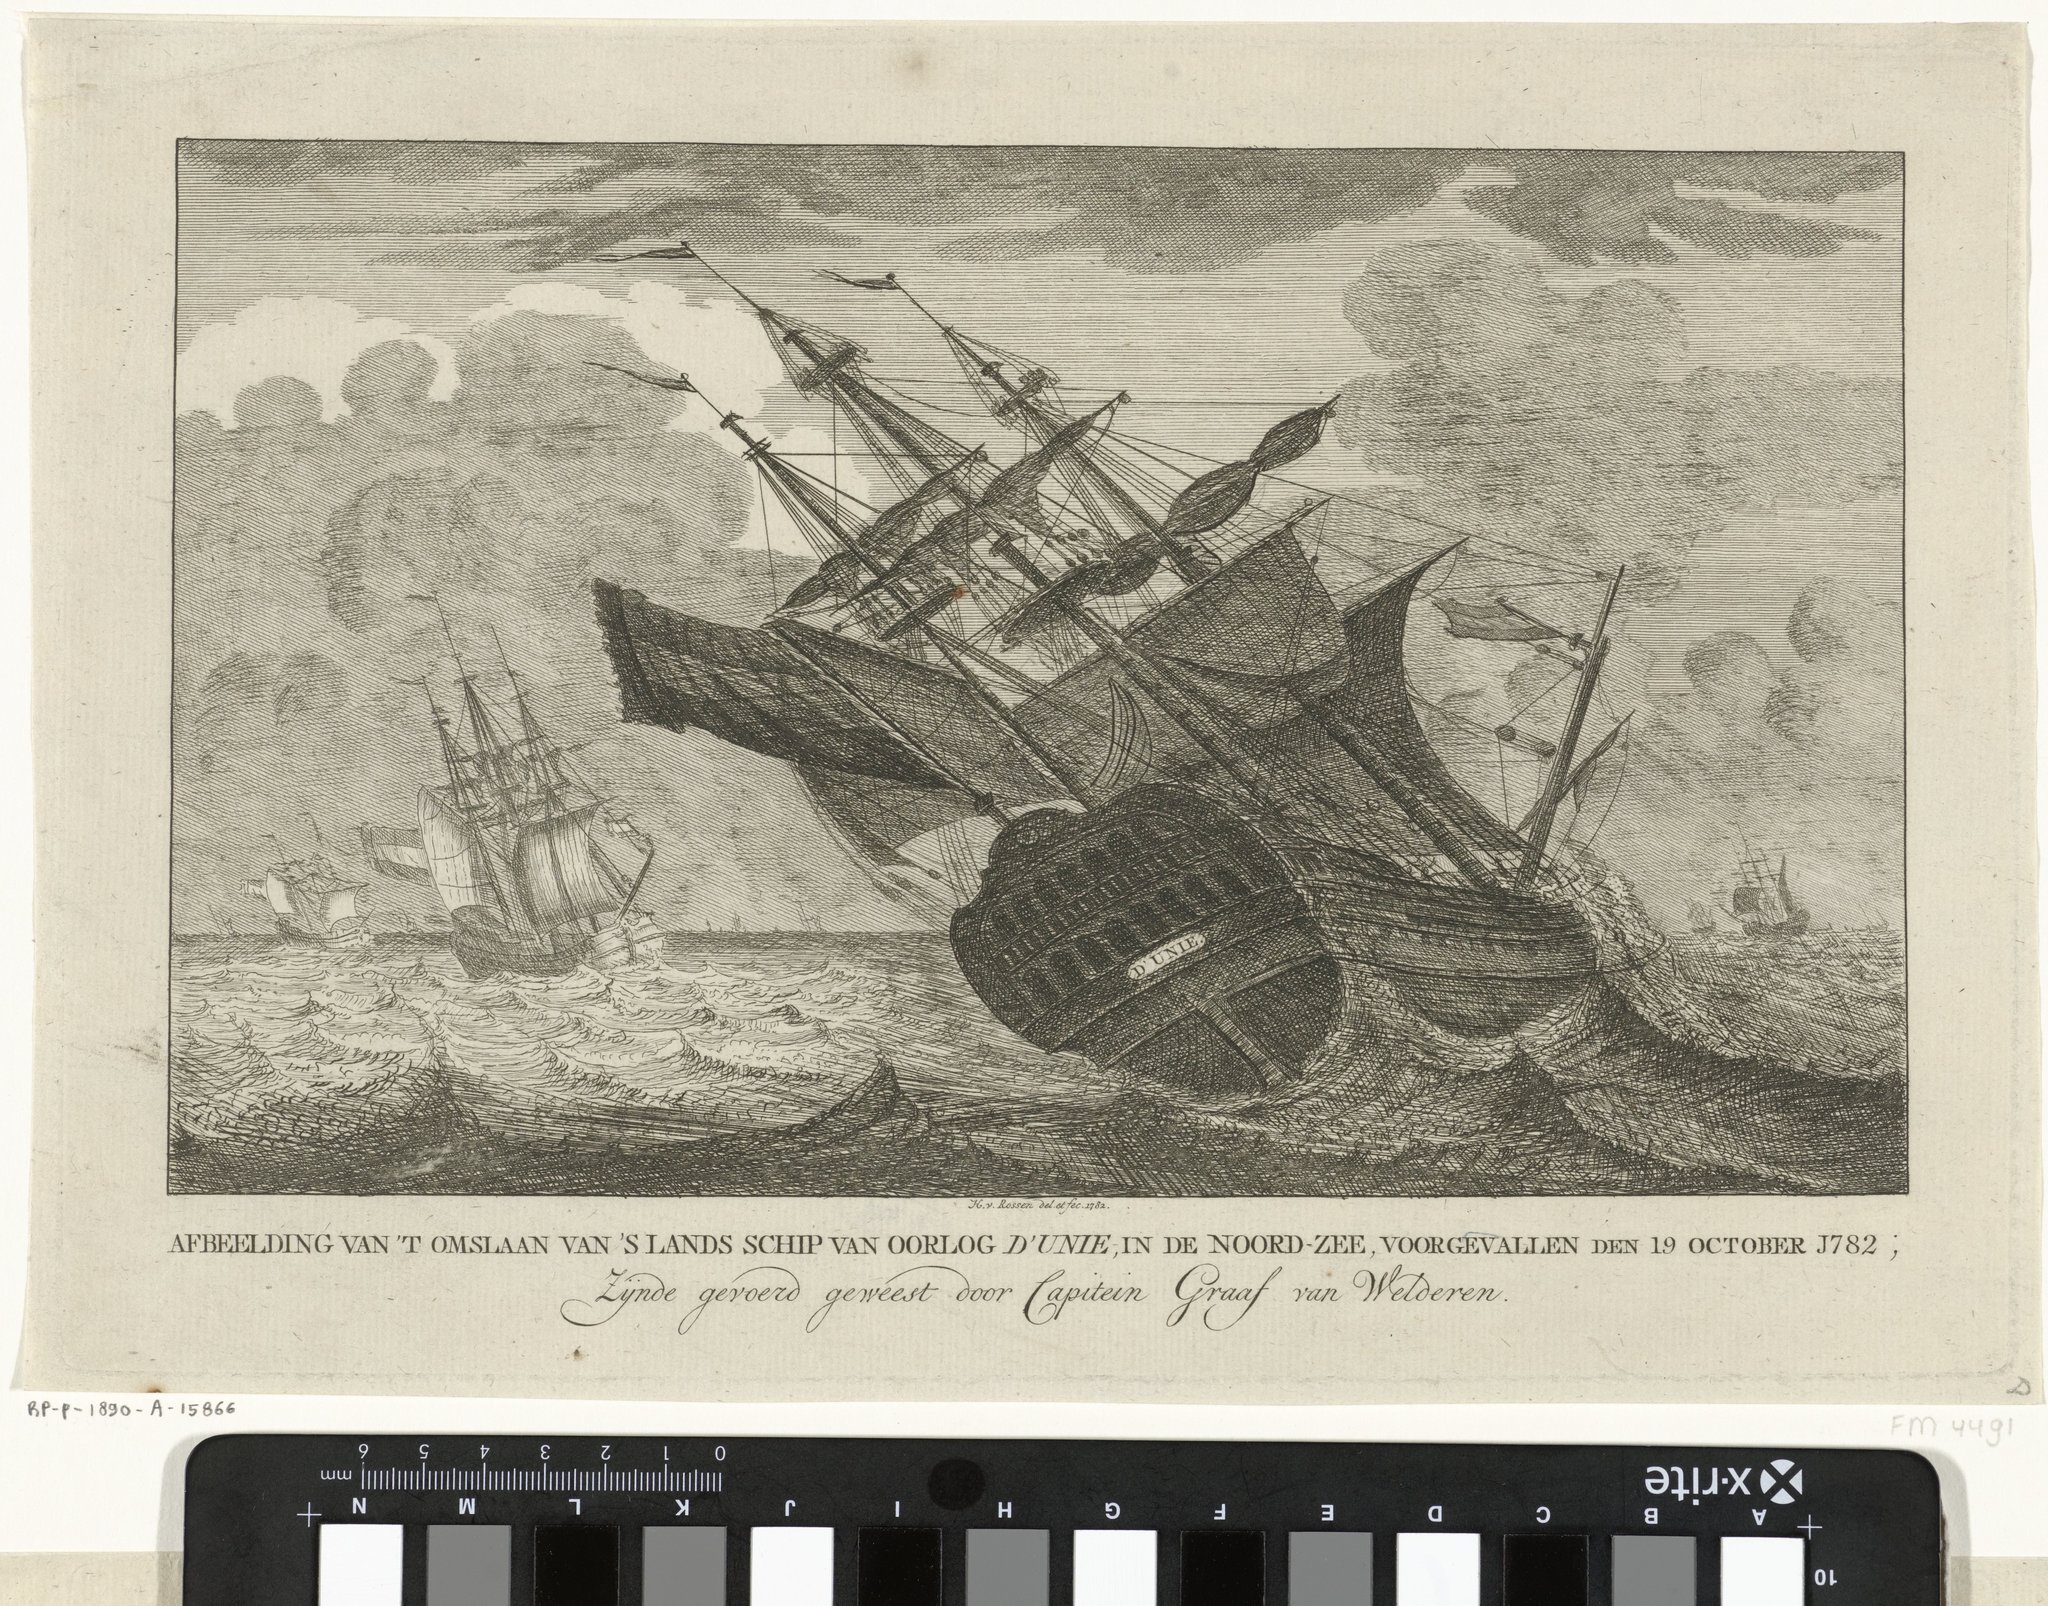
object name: print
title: Afbeelding van 't omslaan van 's lands schip van oorlog d'Unie, in de Noord-zee, voorgevallen den 19 october 1782; Zijnde gevoerd geweest door Capitein Graaf van Welderen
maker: hendrik r. van rossen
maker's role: print maker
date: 1782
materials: paper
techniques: engraving, etching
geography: netherlands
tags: shipwreck (+ propulsion of vehicle, ship, etc. by wind)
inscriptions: collector's mark: Lugt 2228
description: Het vergaan van het oorlogsschip de "Unie" onder bevel van kapitein-ter-zee Louis Marie Graaf van Welderen op de Noordzee op 19 oktober 1782.